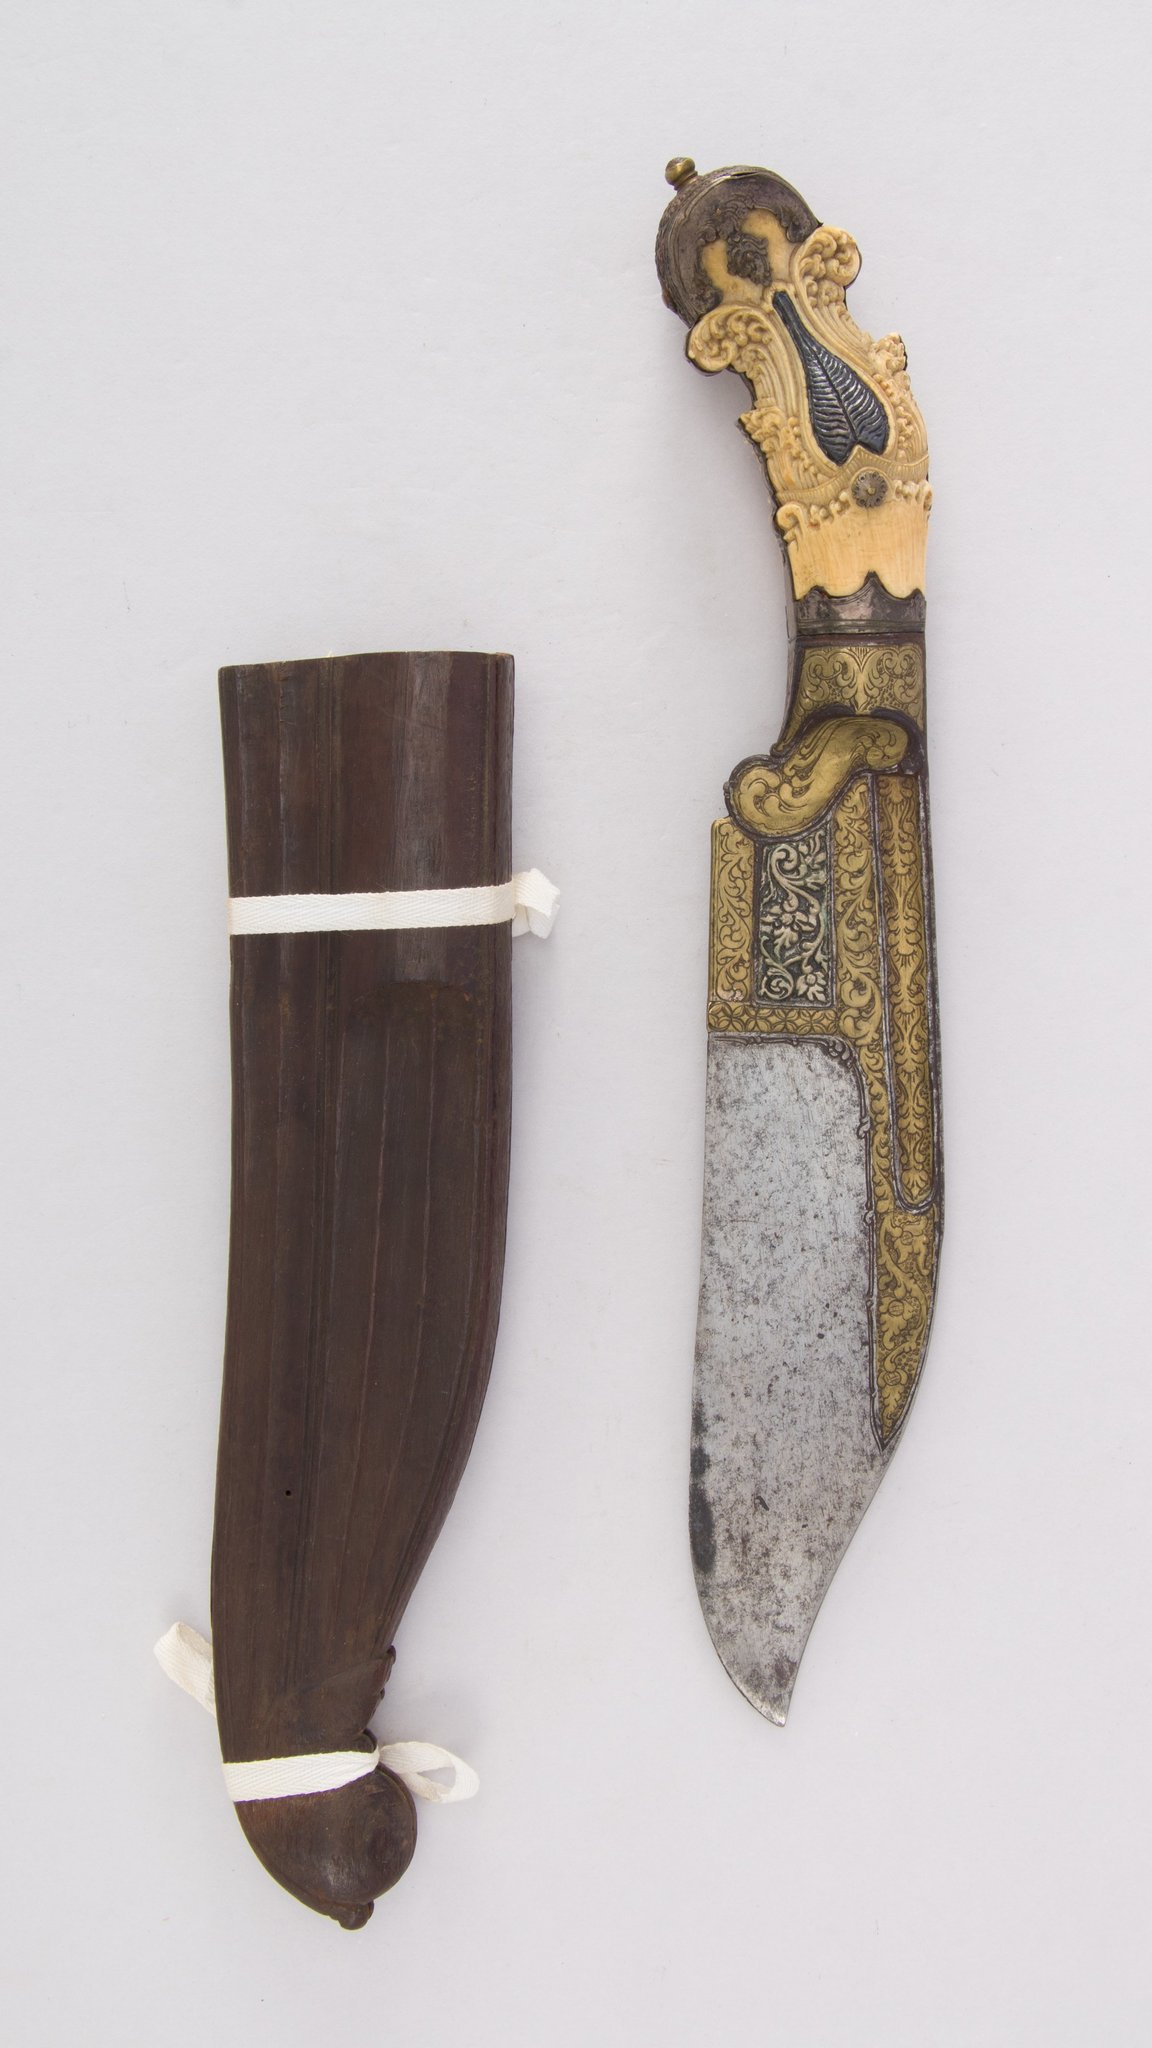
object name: knife piha kaetta with sheath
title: Knife (Piha Kaetta) with Sheath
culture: sri lankan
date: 1701-1900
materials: brass, ivory, silver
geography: sri lanka